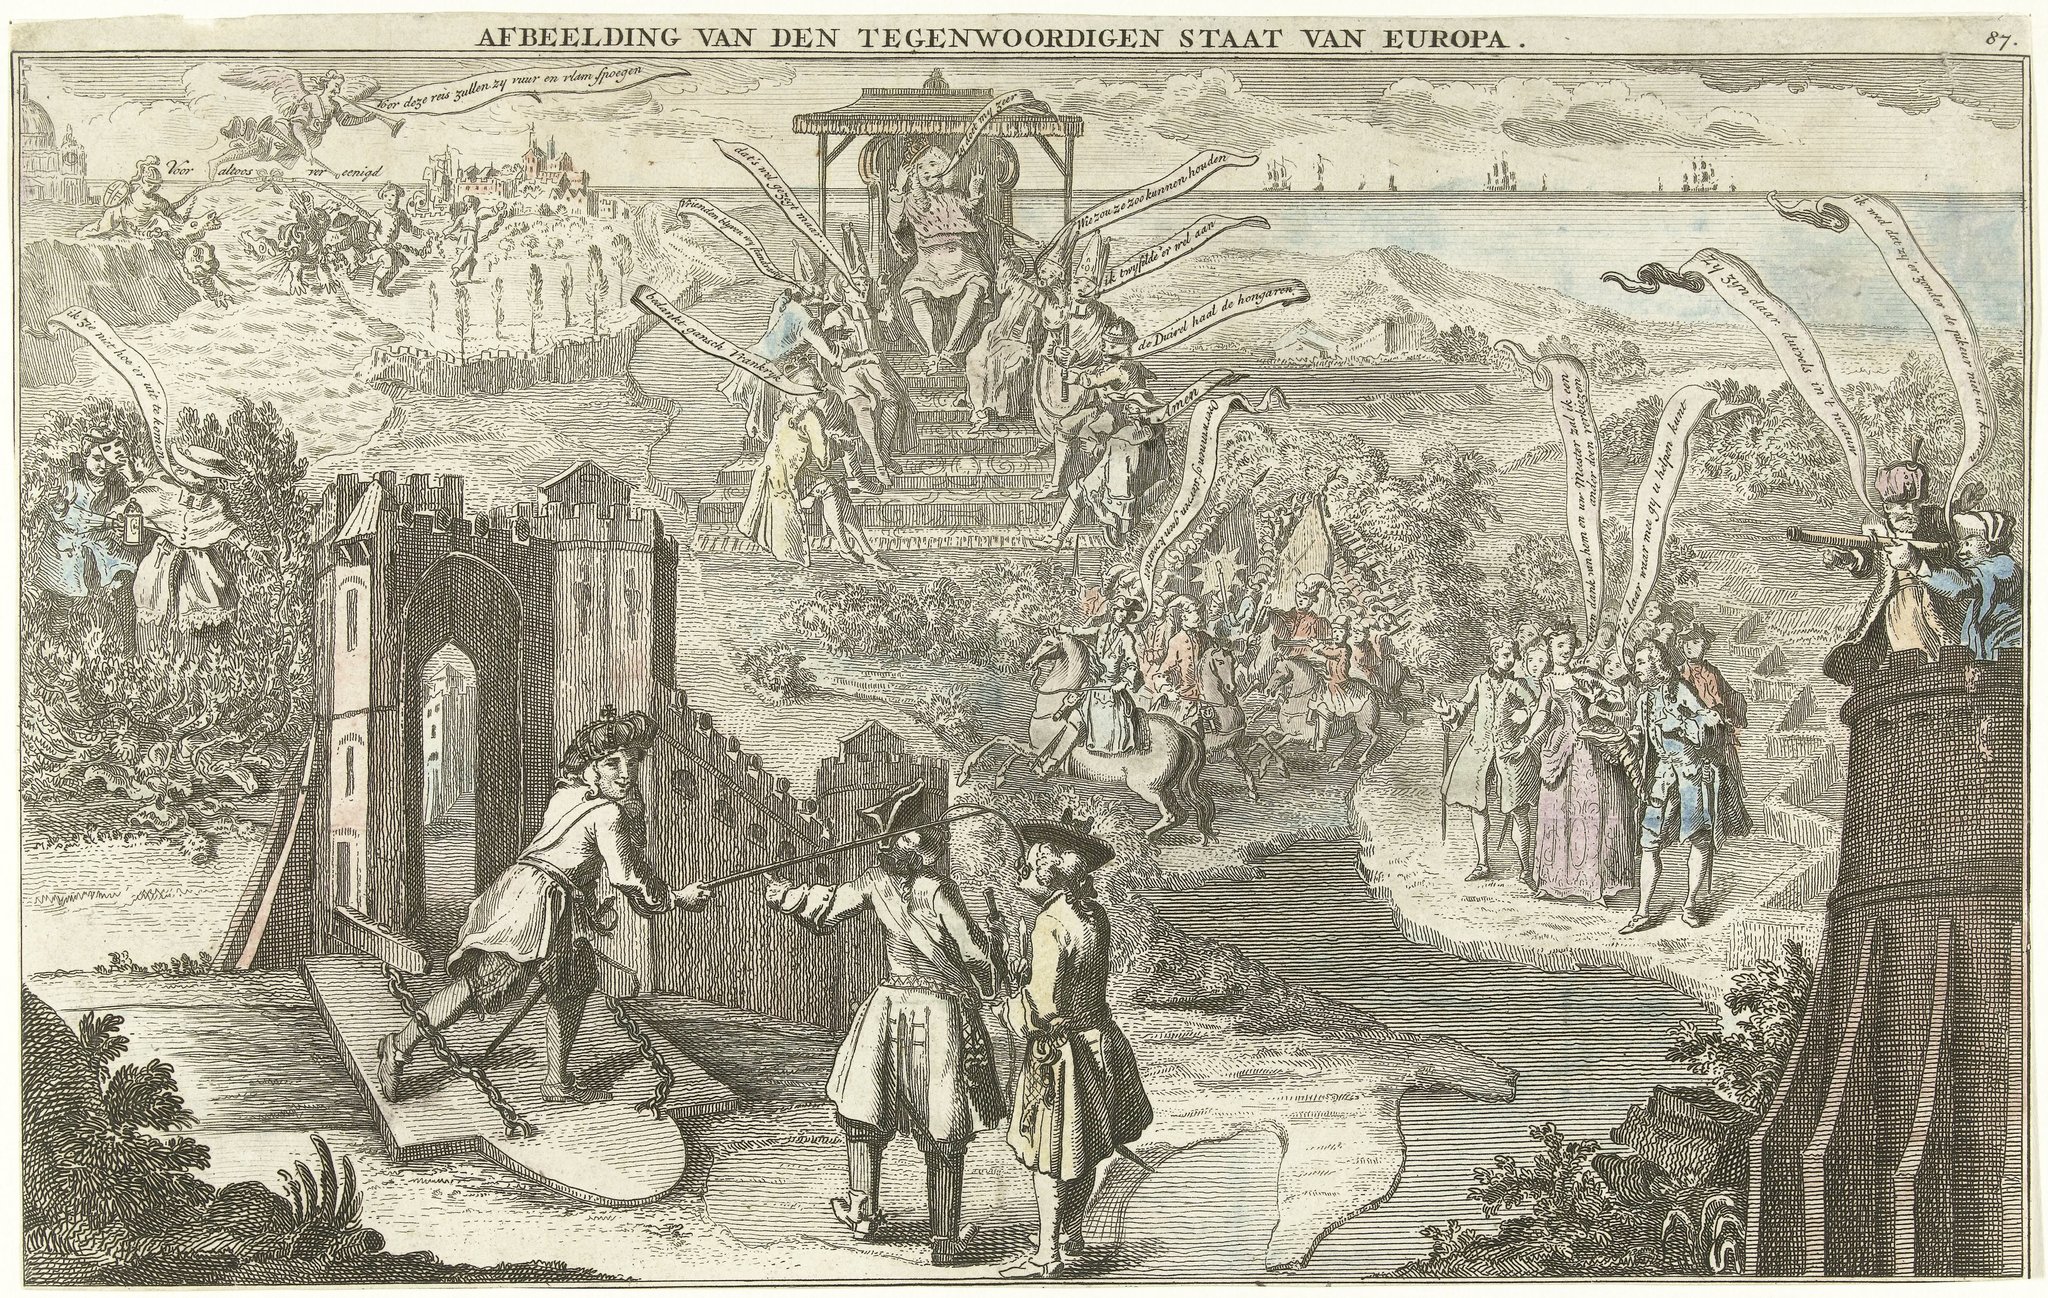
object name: print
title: Afbeelding van den tegenwoordigen staat van Europa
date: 1742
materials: paper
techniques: etching, hand coloring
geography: england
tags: france, vienna, maria theresia (rooms-duits keizerin), karel vii albrecht (duits keizer), political caricatures and satires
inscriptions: collector's mark: Lugt 2228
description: De tegenwoordige staat van Europa, 1742. Sterk versimpelde landkaart van Europa met centraal de keurvost van Beieren als keizer Karel VII op de troon, rechts hiervan staat Maria Theresia met haar gevolg. Rechtsonder kijken Turken vanuit een toren met verbazing naar de verwikkelingen in Europa. Links is kardinaal Fleury verward in de doornenstruiken, daarboven de verbintenis van Engeland met Hannover. Centraal een vorst die twee andere mannen een bril voorhoudt. Allegorie op de Oostenrijkse successieoorlog. Gemerkt rechtsboven: 87.